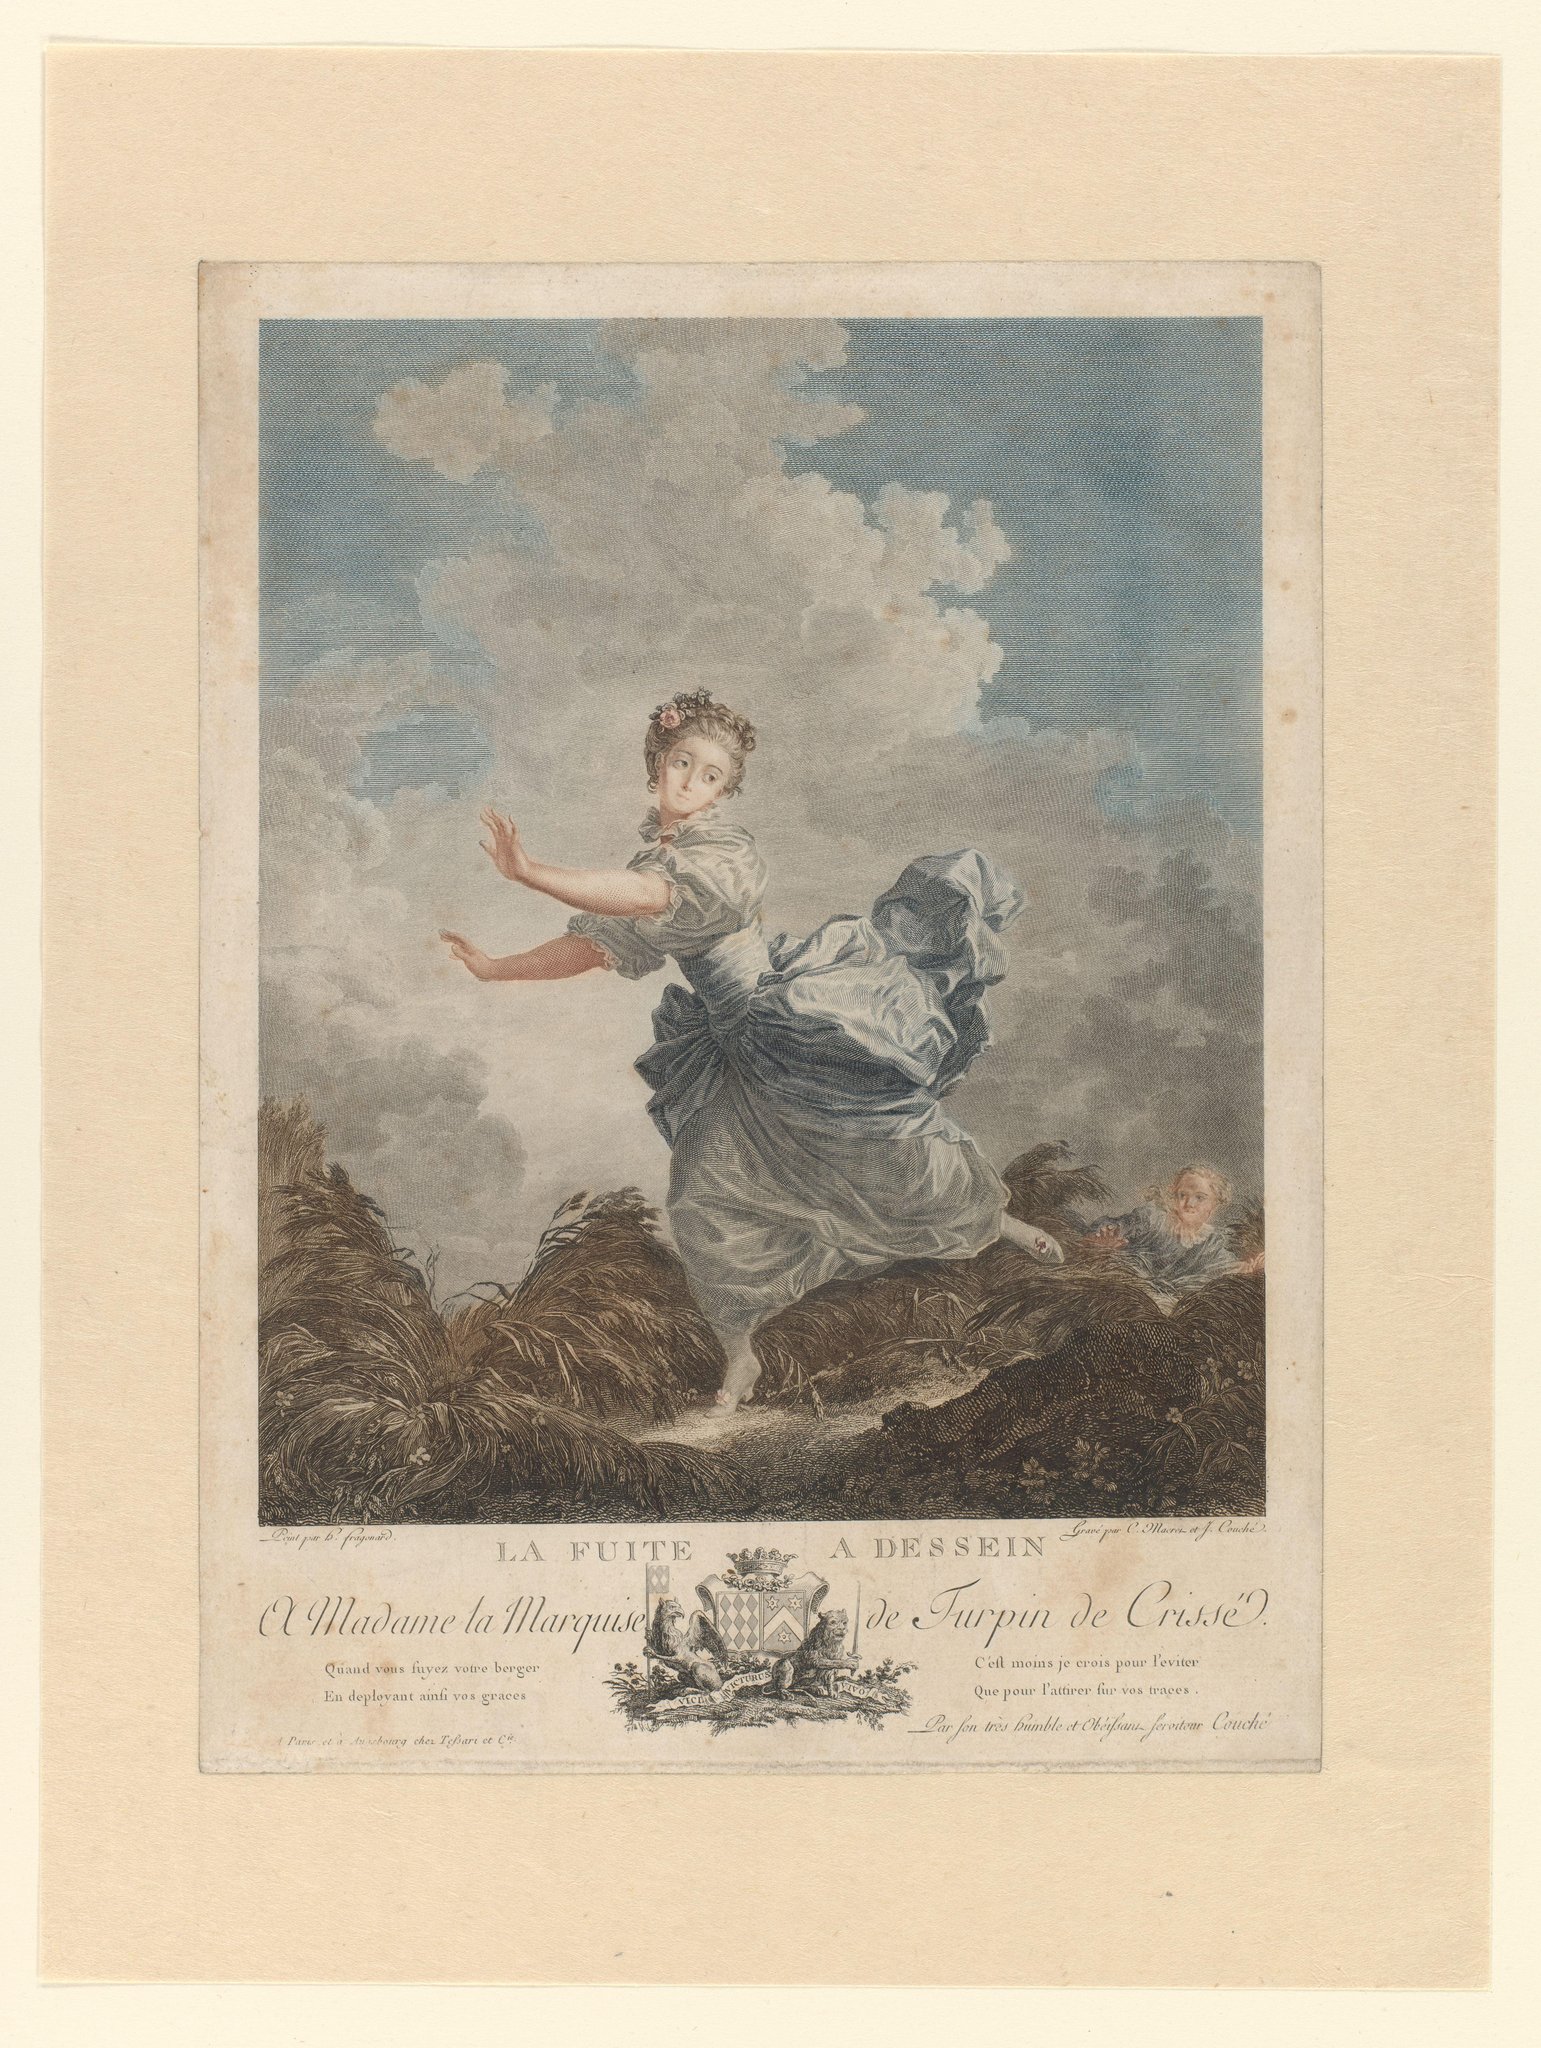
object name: print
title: La Fuite a Dessein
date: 1760-1836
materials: paper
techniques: engraving, lithography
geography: paris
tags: adolescent, young woman, maiden, catch (~ running game), courting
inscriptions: collector's mark: Lugt 2228